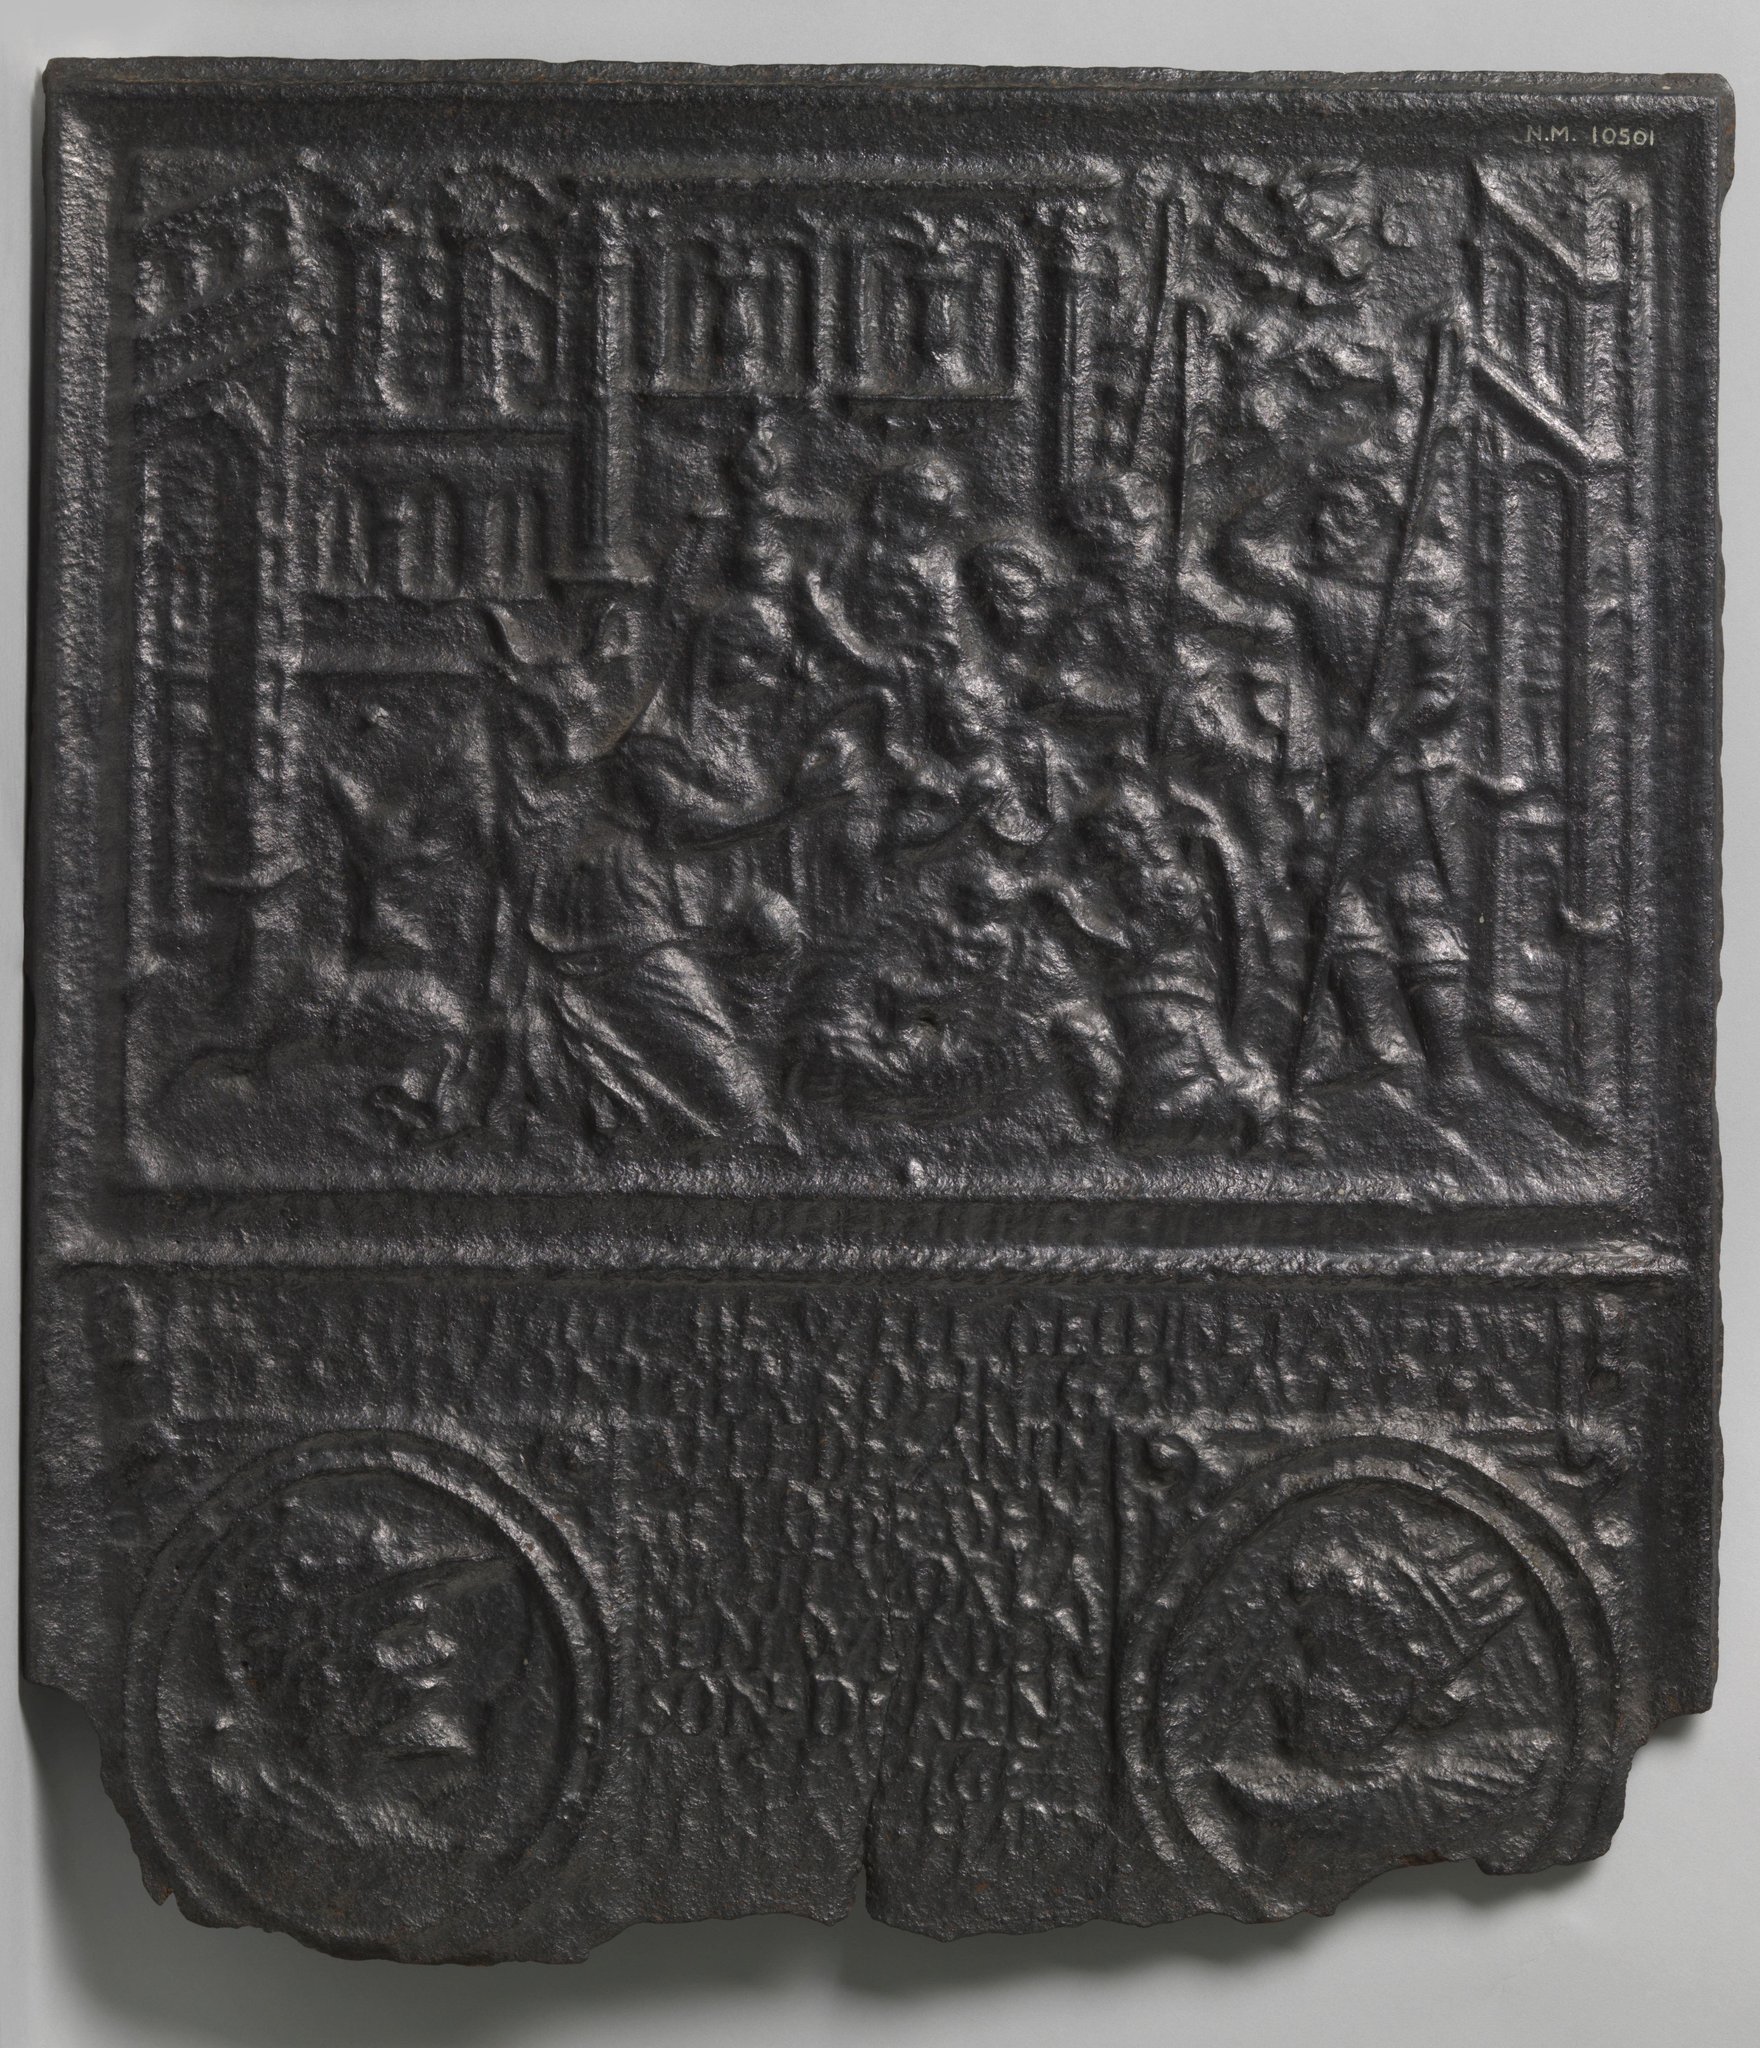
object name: stove plate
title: Kachelplaat met de aanbidding door de herders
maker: Anonymous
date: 1550-1600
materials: iron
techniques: casting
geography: germany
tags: adoration of the christ-child by the shepherds; mary and joseph present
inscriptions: inscription, inscription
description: Kachelplaat van gietijzer, in twee zones verdeeld. In de bovenste zone een voorstelling van het kind Jezus gedragen in een krib met stro. Links van hem knielt Maria. Rechts van Jezus een geknielde herder. Achter Christus, Maria en de herder staan nog enkele herders, waaronder een met een staf en hoed. In de onderste zone twee medaillons met een portret en profil van een man en een vrouw. De rest van de onderste zone is gevuld met tekst, grotendeels onleesbaar. Tussen de twee zones is een band met onleesbare tekst.